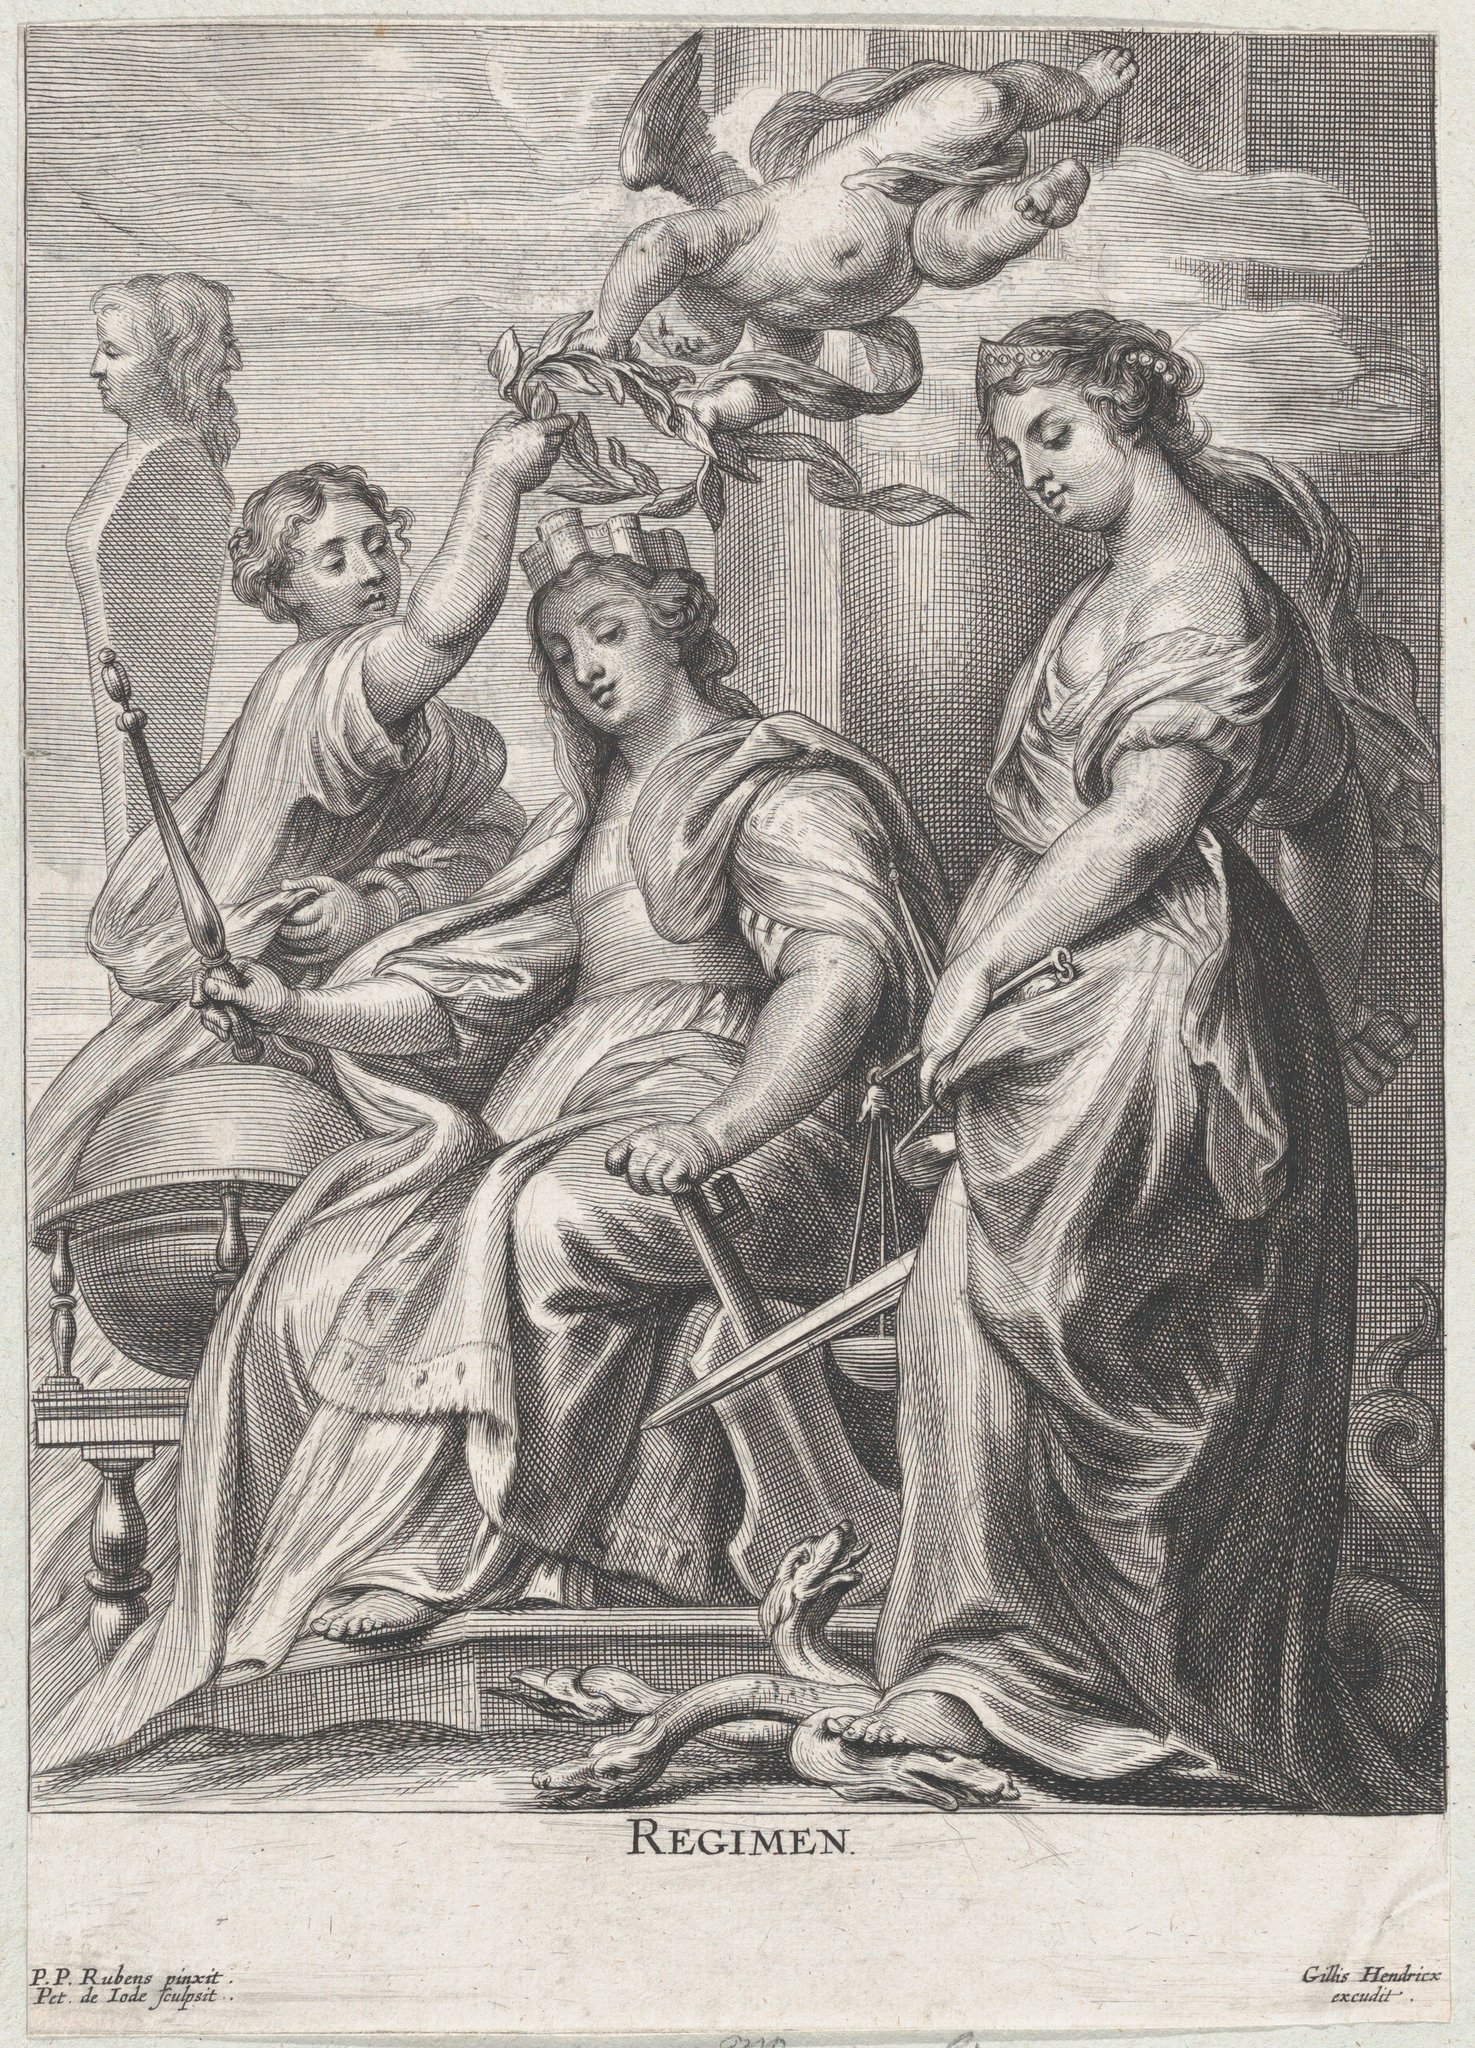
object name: print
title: Allegory of Good Government, seated at center and being crowned by a putto and a woman at left, Justice standing atop a hydra at right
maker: pieter de jode (ii)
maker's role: artist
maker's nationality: flemish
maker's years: 1606-1674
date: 1640-1674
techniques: engraving